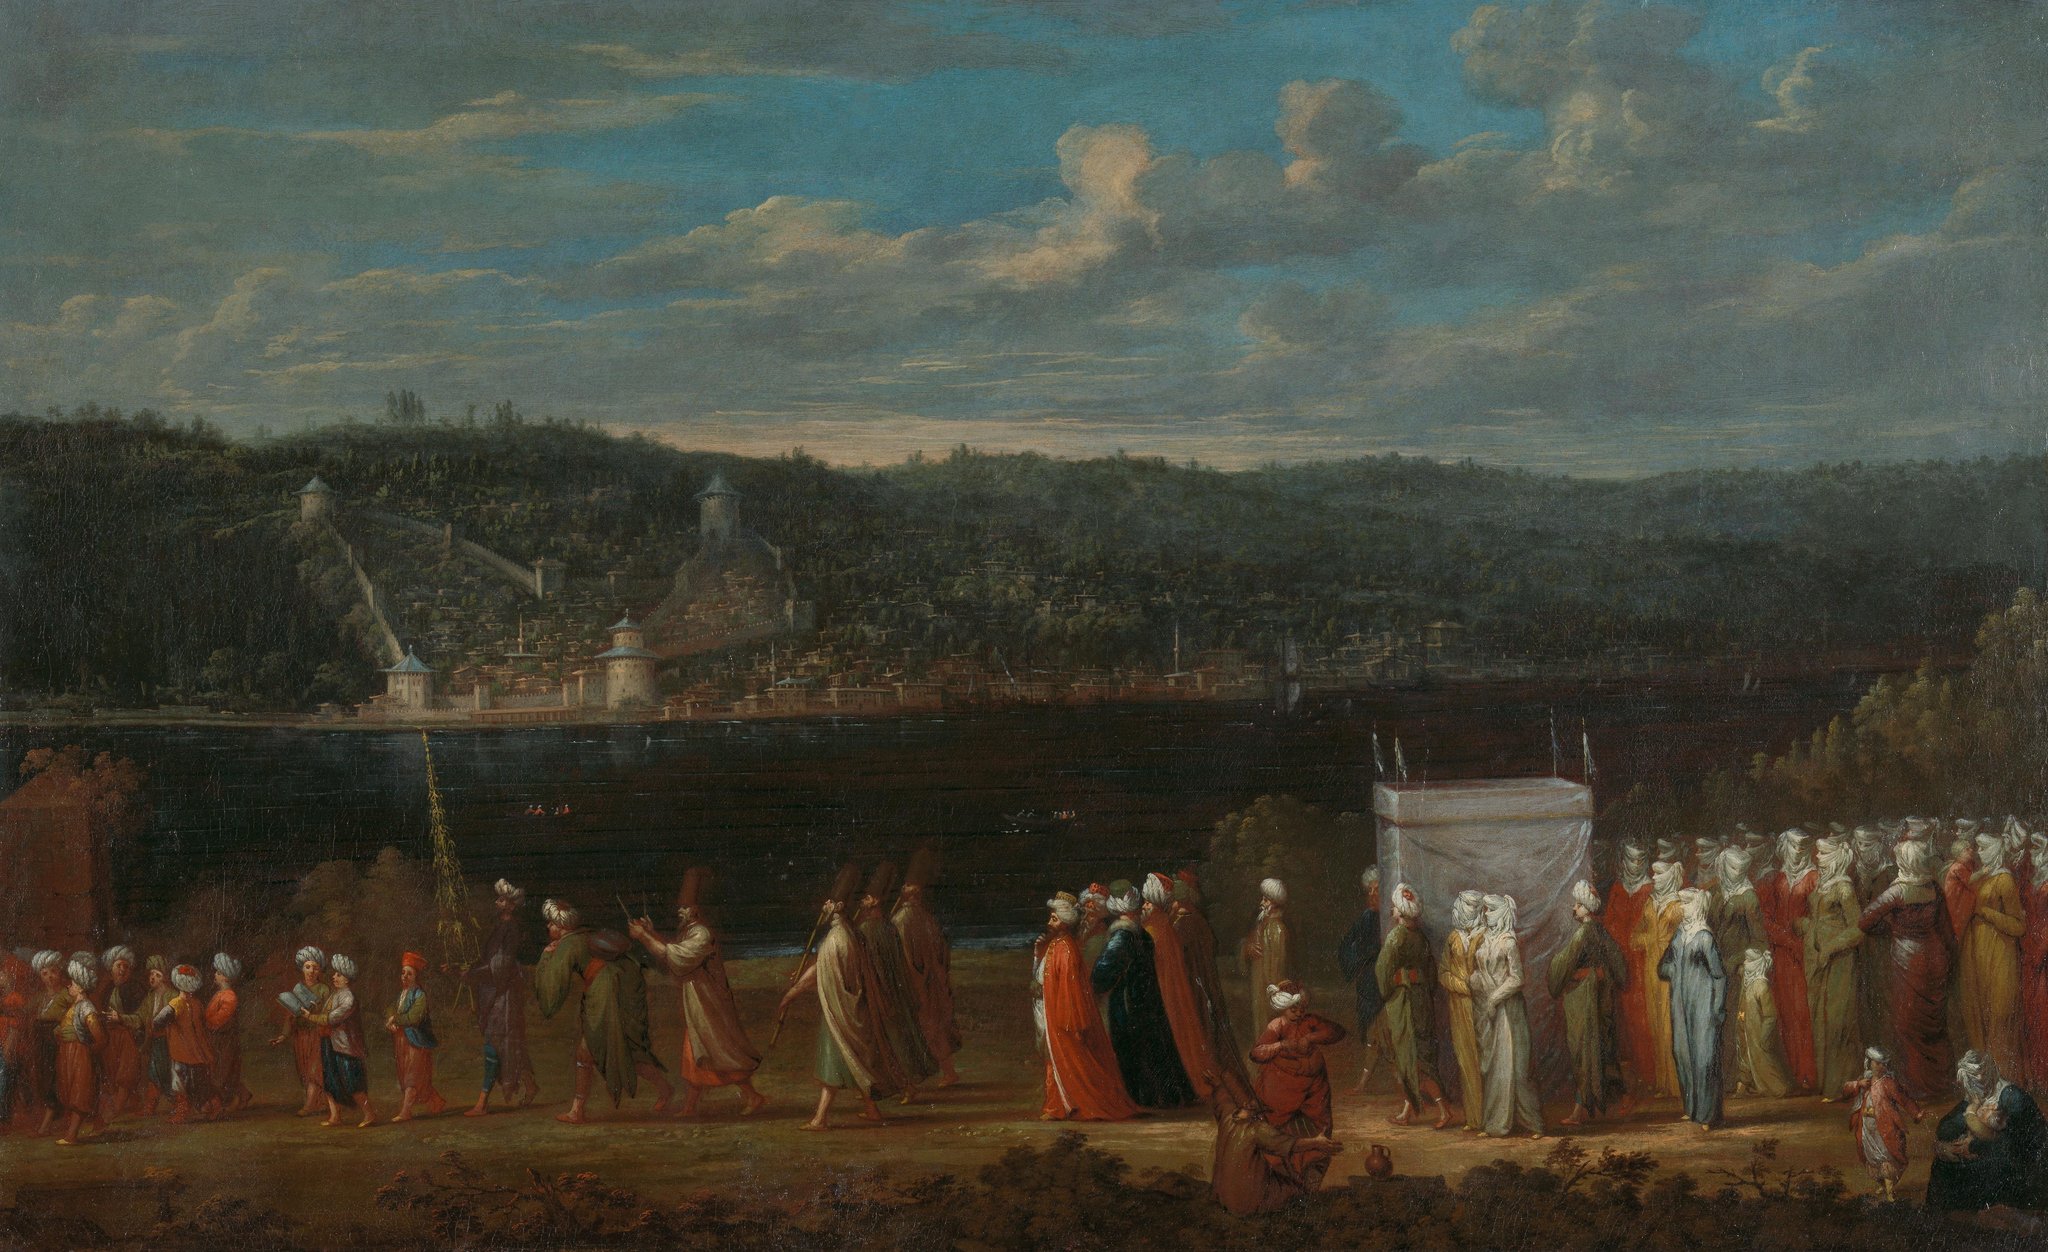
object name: painting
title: Wedding procession on the Bosphorus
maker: jean baptiste vanmour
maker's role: painter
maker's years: 1671-1737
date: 1720-1737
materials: canvas, oil, paint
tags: (civil) marriage ceremonies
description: A colourful procession along the Bosporus leads a bride to the house of her future husband. She is mounted on horseback under a baldachin carried by four men. Walking directly in front of the tent is the imam, the religious leader, who will consecrate their marriage. The pyramidal tower made of gold thread in the shape of ears of corn is a symbol of fertility.